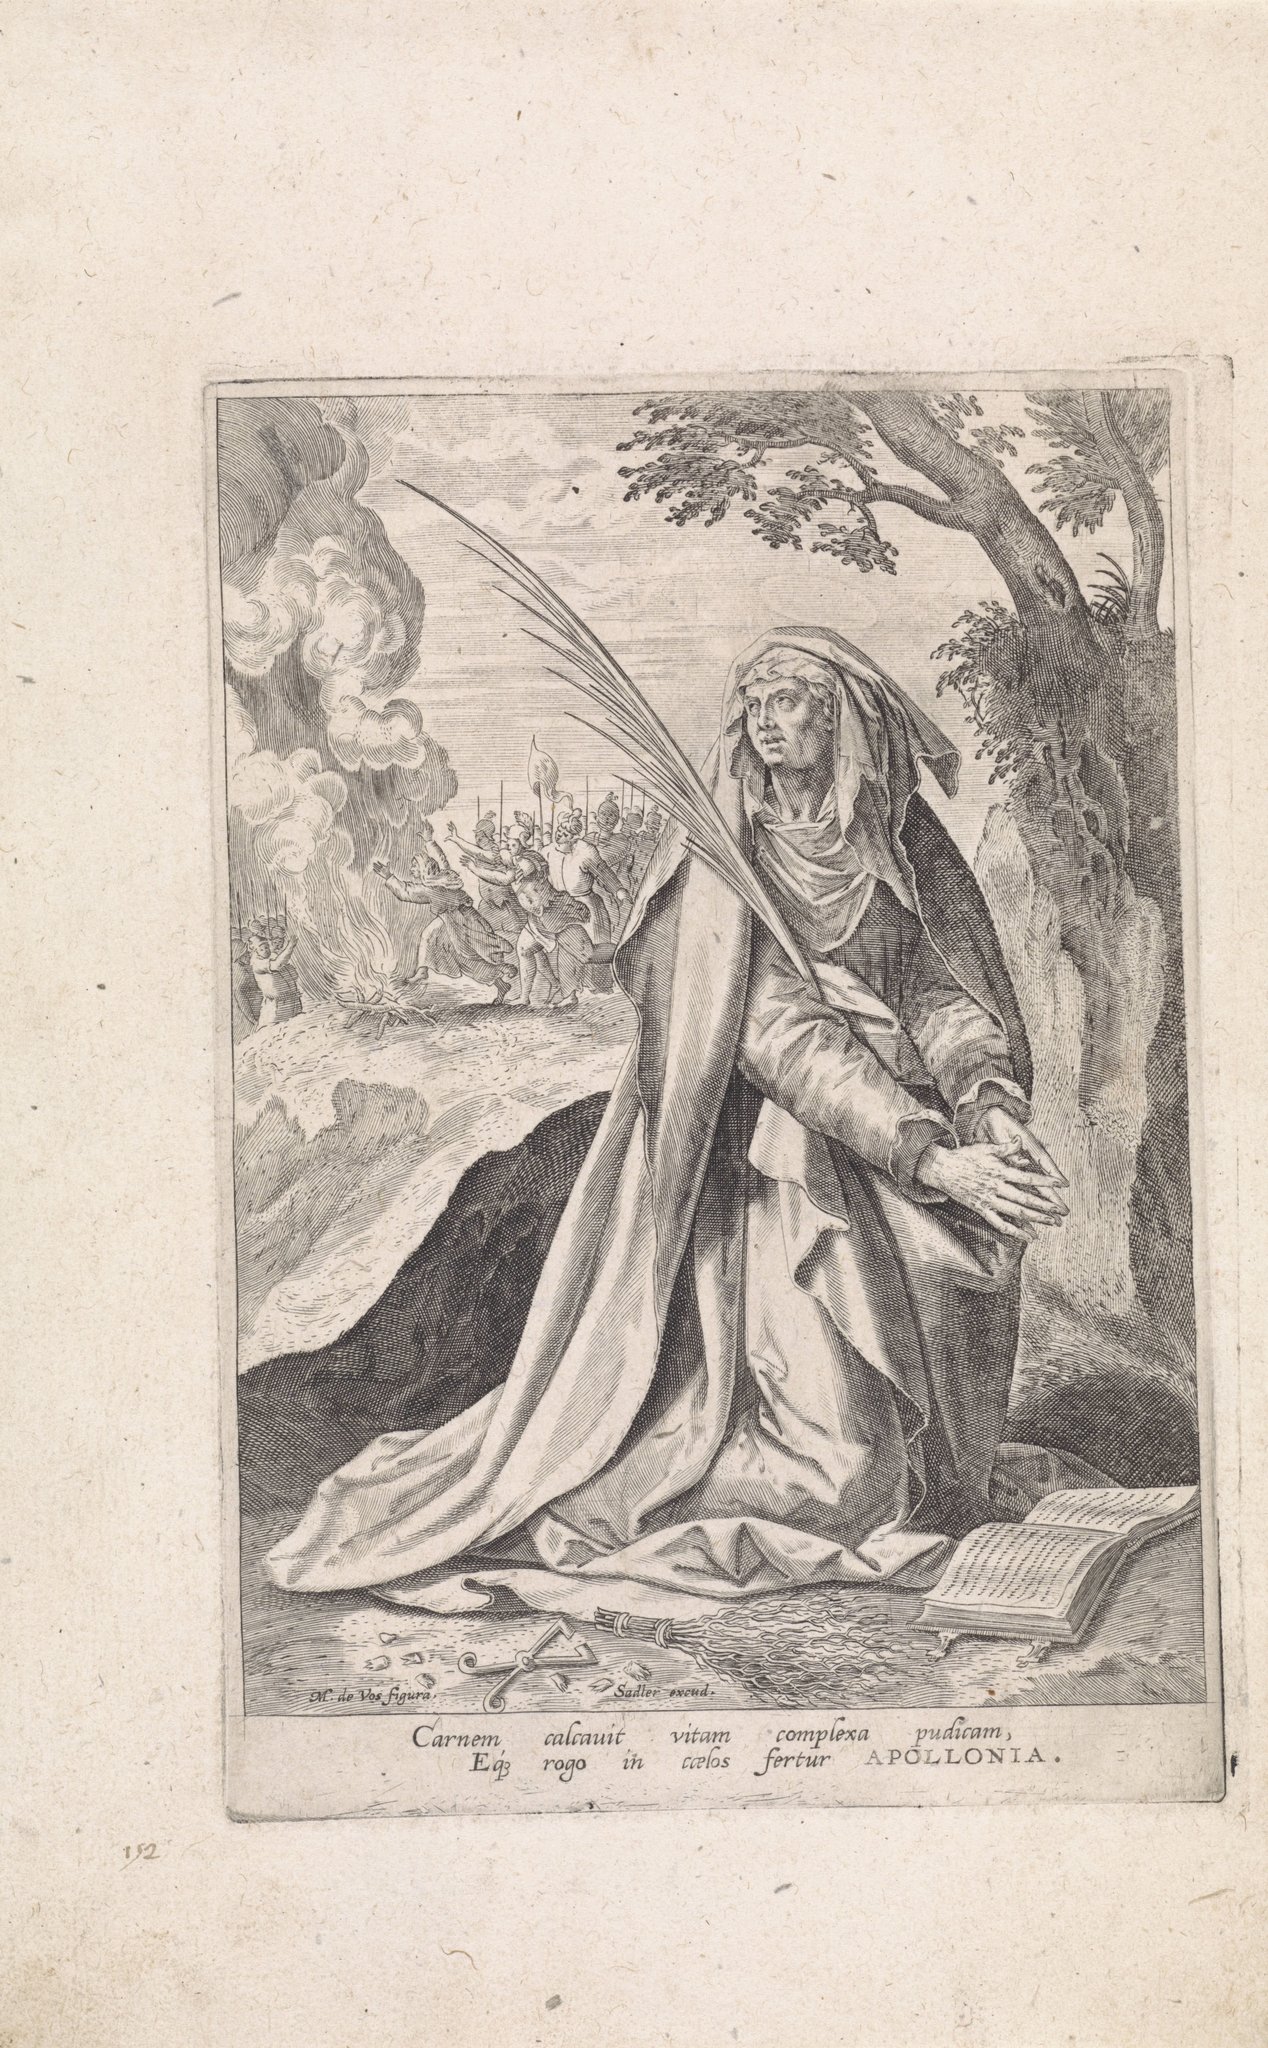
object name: print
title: Heilige Apollonia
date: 1583-1587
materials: paper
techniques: engraving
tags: the virgin martyr apollonia of alexandria; possible attributes: book, crown, palm-branch, tooth in pincers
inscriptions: collector's mark: Lugt 2228, number: ‘152’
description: De H. Apollonia, knielend naar rechts, het hoofd naar links. Naast haar een open boek en een roede. Op de achtergrond springt de H. Apollonia uit eigen wil op de brandstapel. De vierde prent van een zeventiendelige serie met vrouwelijke heiligen.